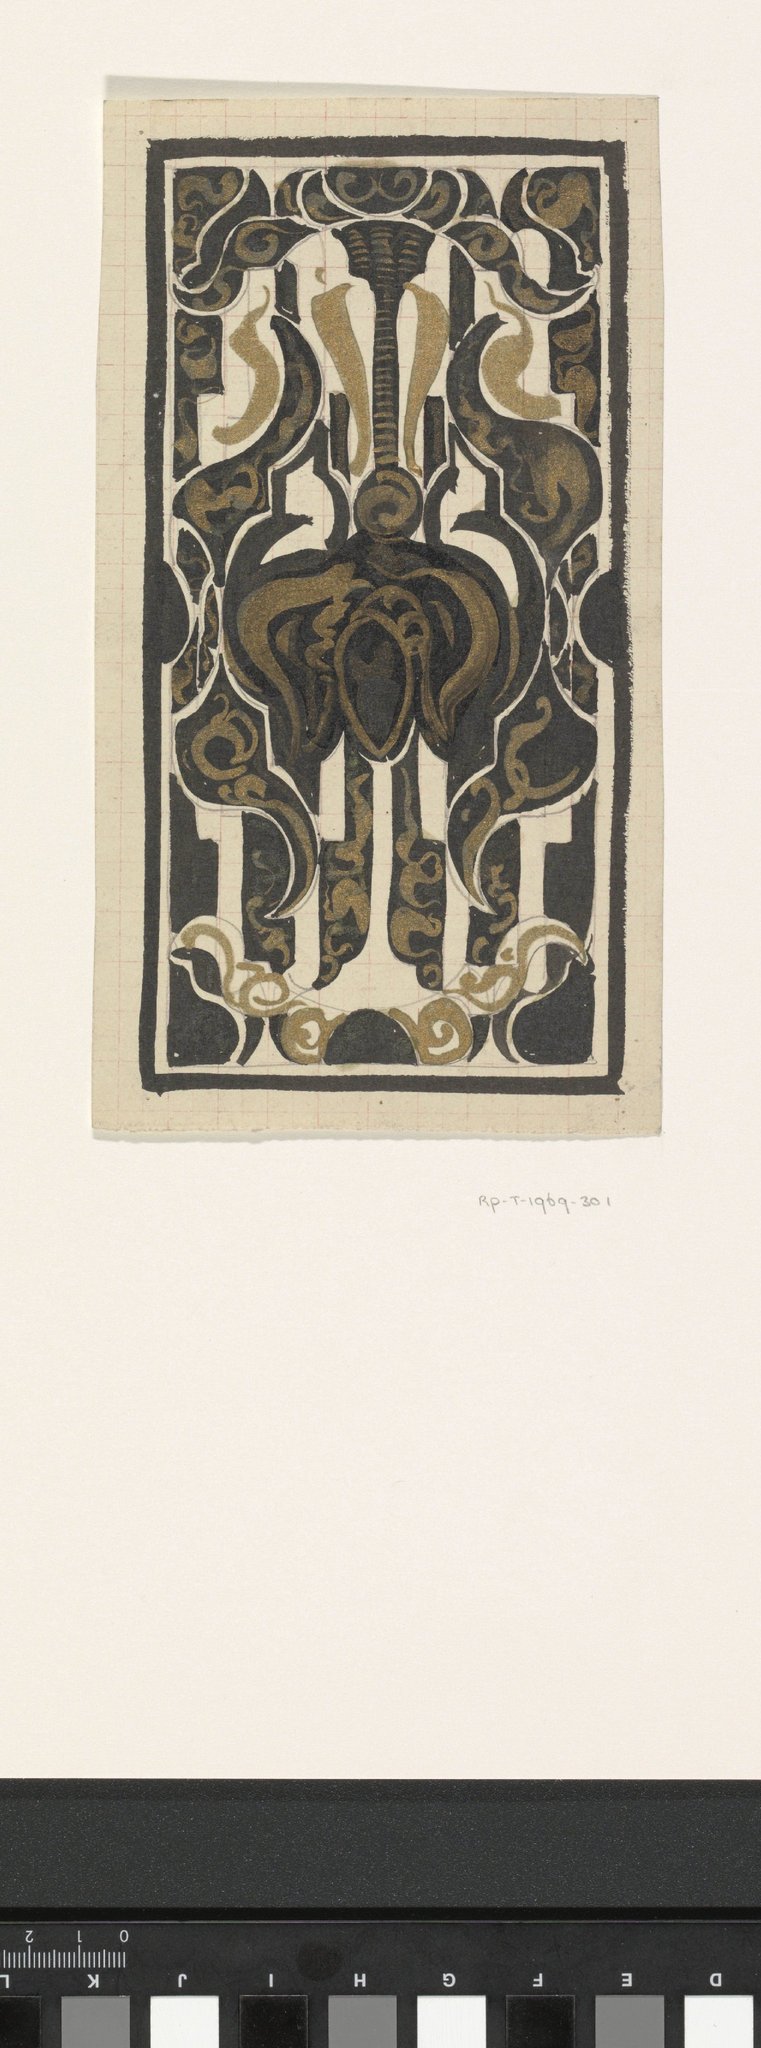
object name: design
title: Abstract decoratief ontwerp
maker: carel adolph lion cachet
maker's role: draughtsman, print maker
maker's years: 1864-1945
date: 1874-1945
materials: pencil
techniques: brush